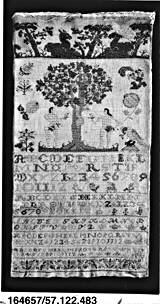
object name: sampler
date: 1701-1800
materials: linen, silk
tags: human figures,trees